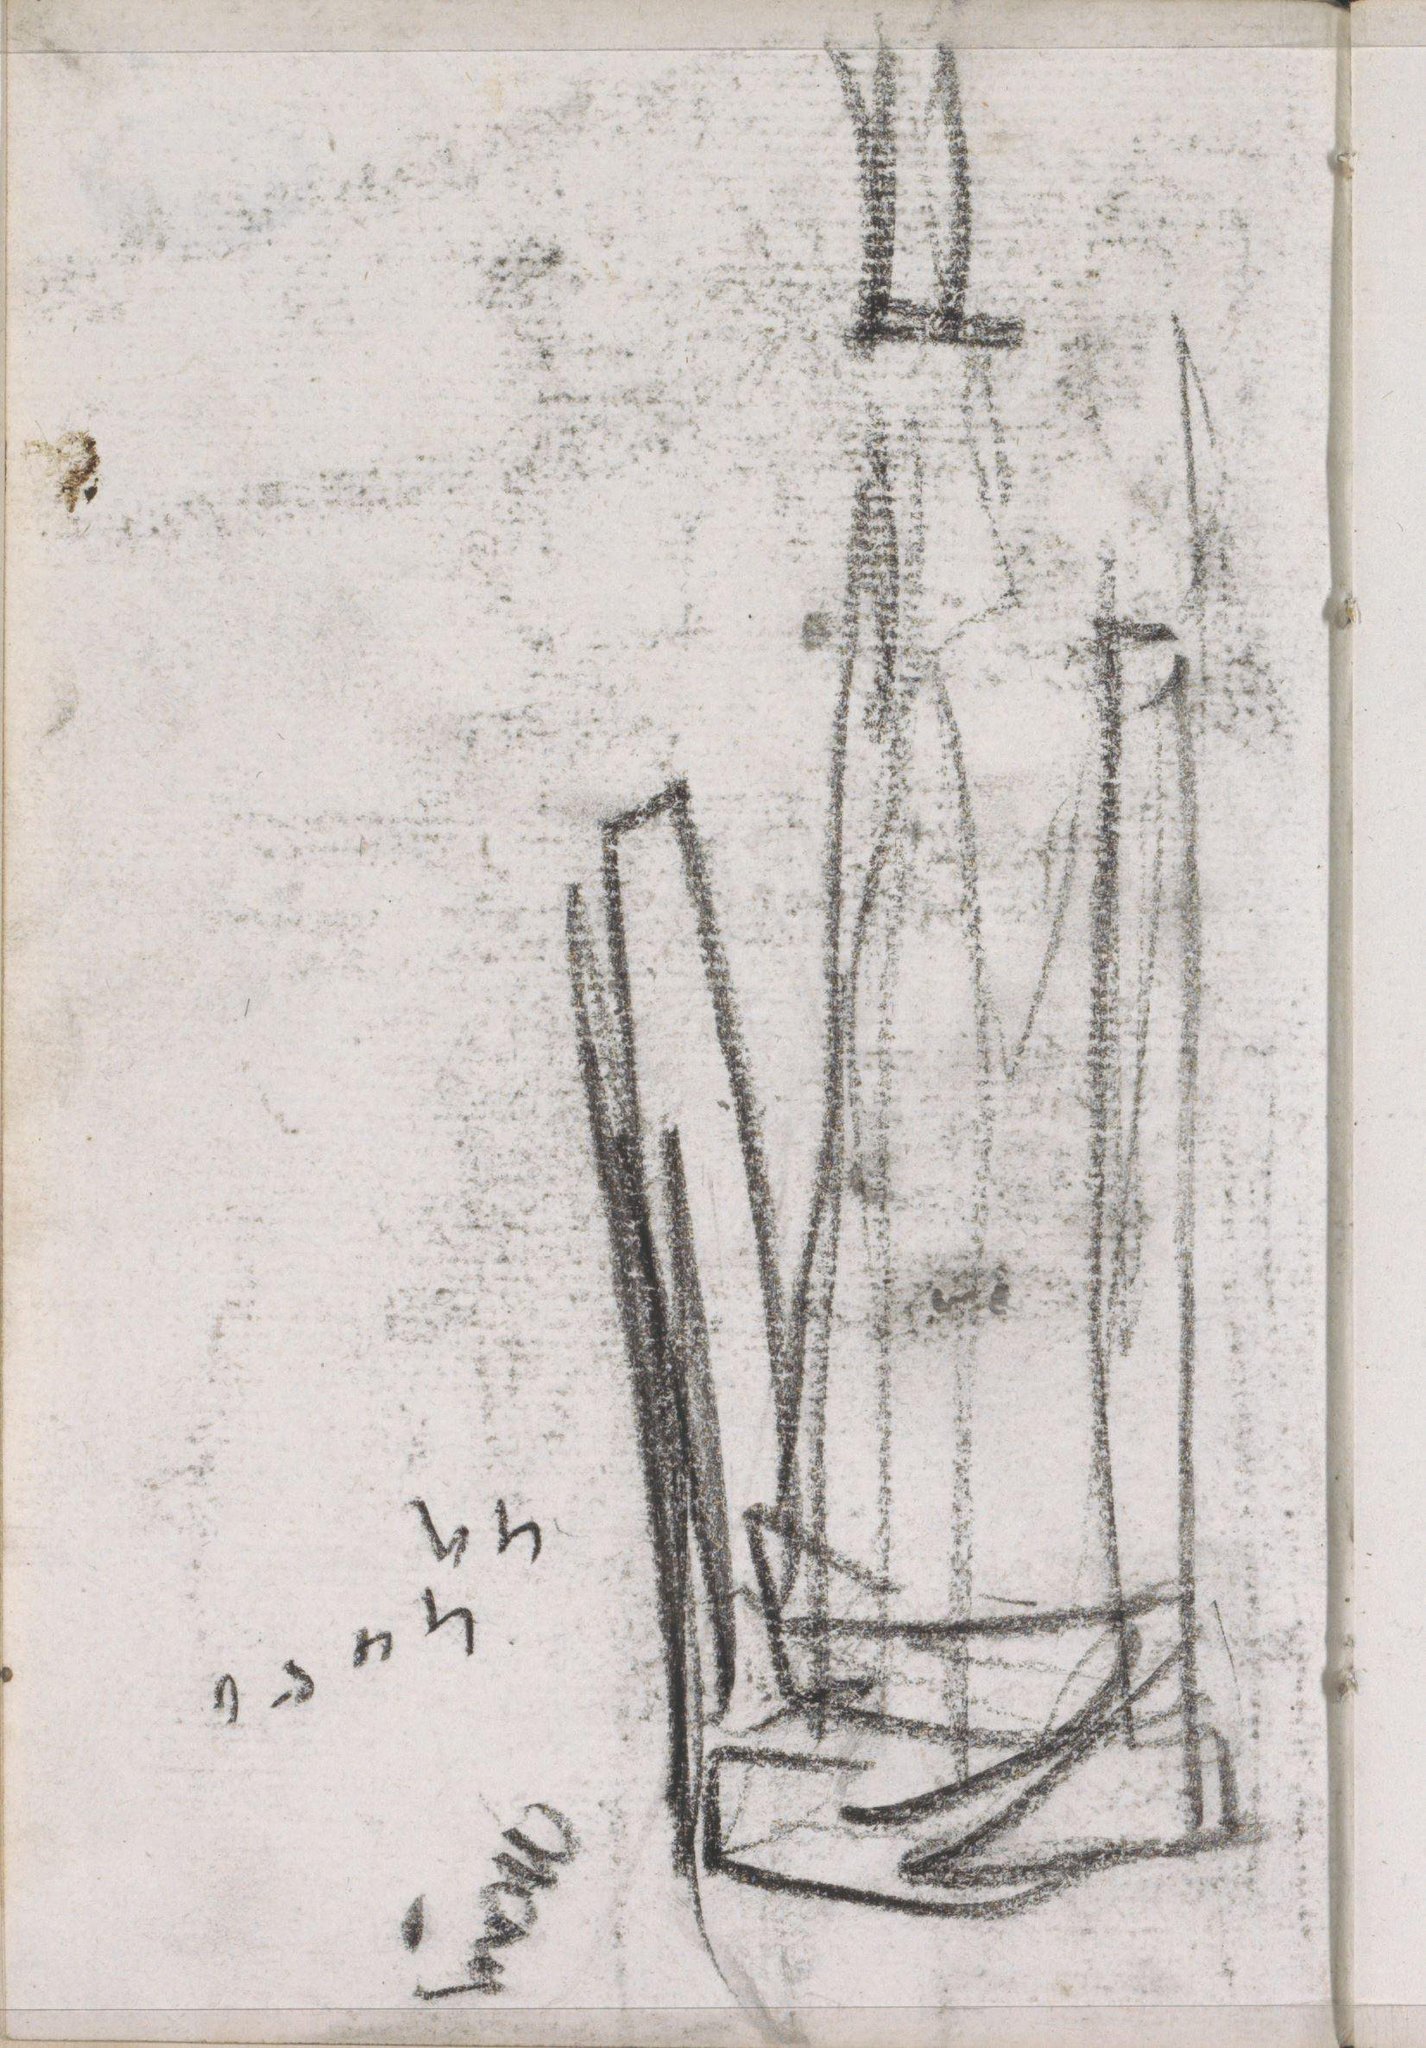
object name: sketchbook leaf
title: Studie, mogelijk van een boot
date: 1906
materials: chalk, paper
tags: ships (in general)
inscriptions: annotation: ‘[...]’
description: Pagina 13 uit een schetsboek met 14 bladen.